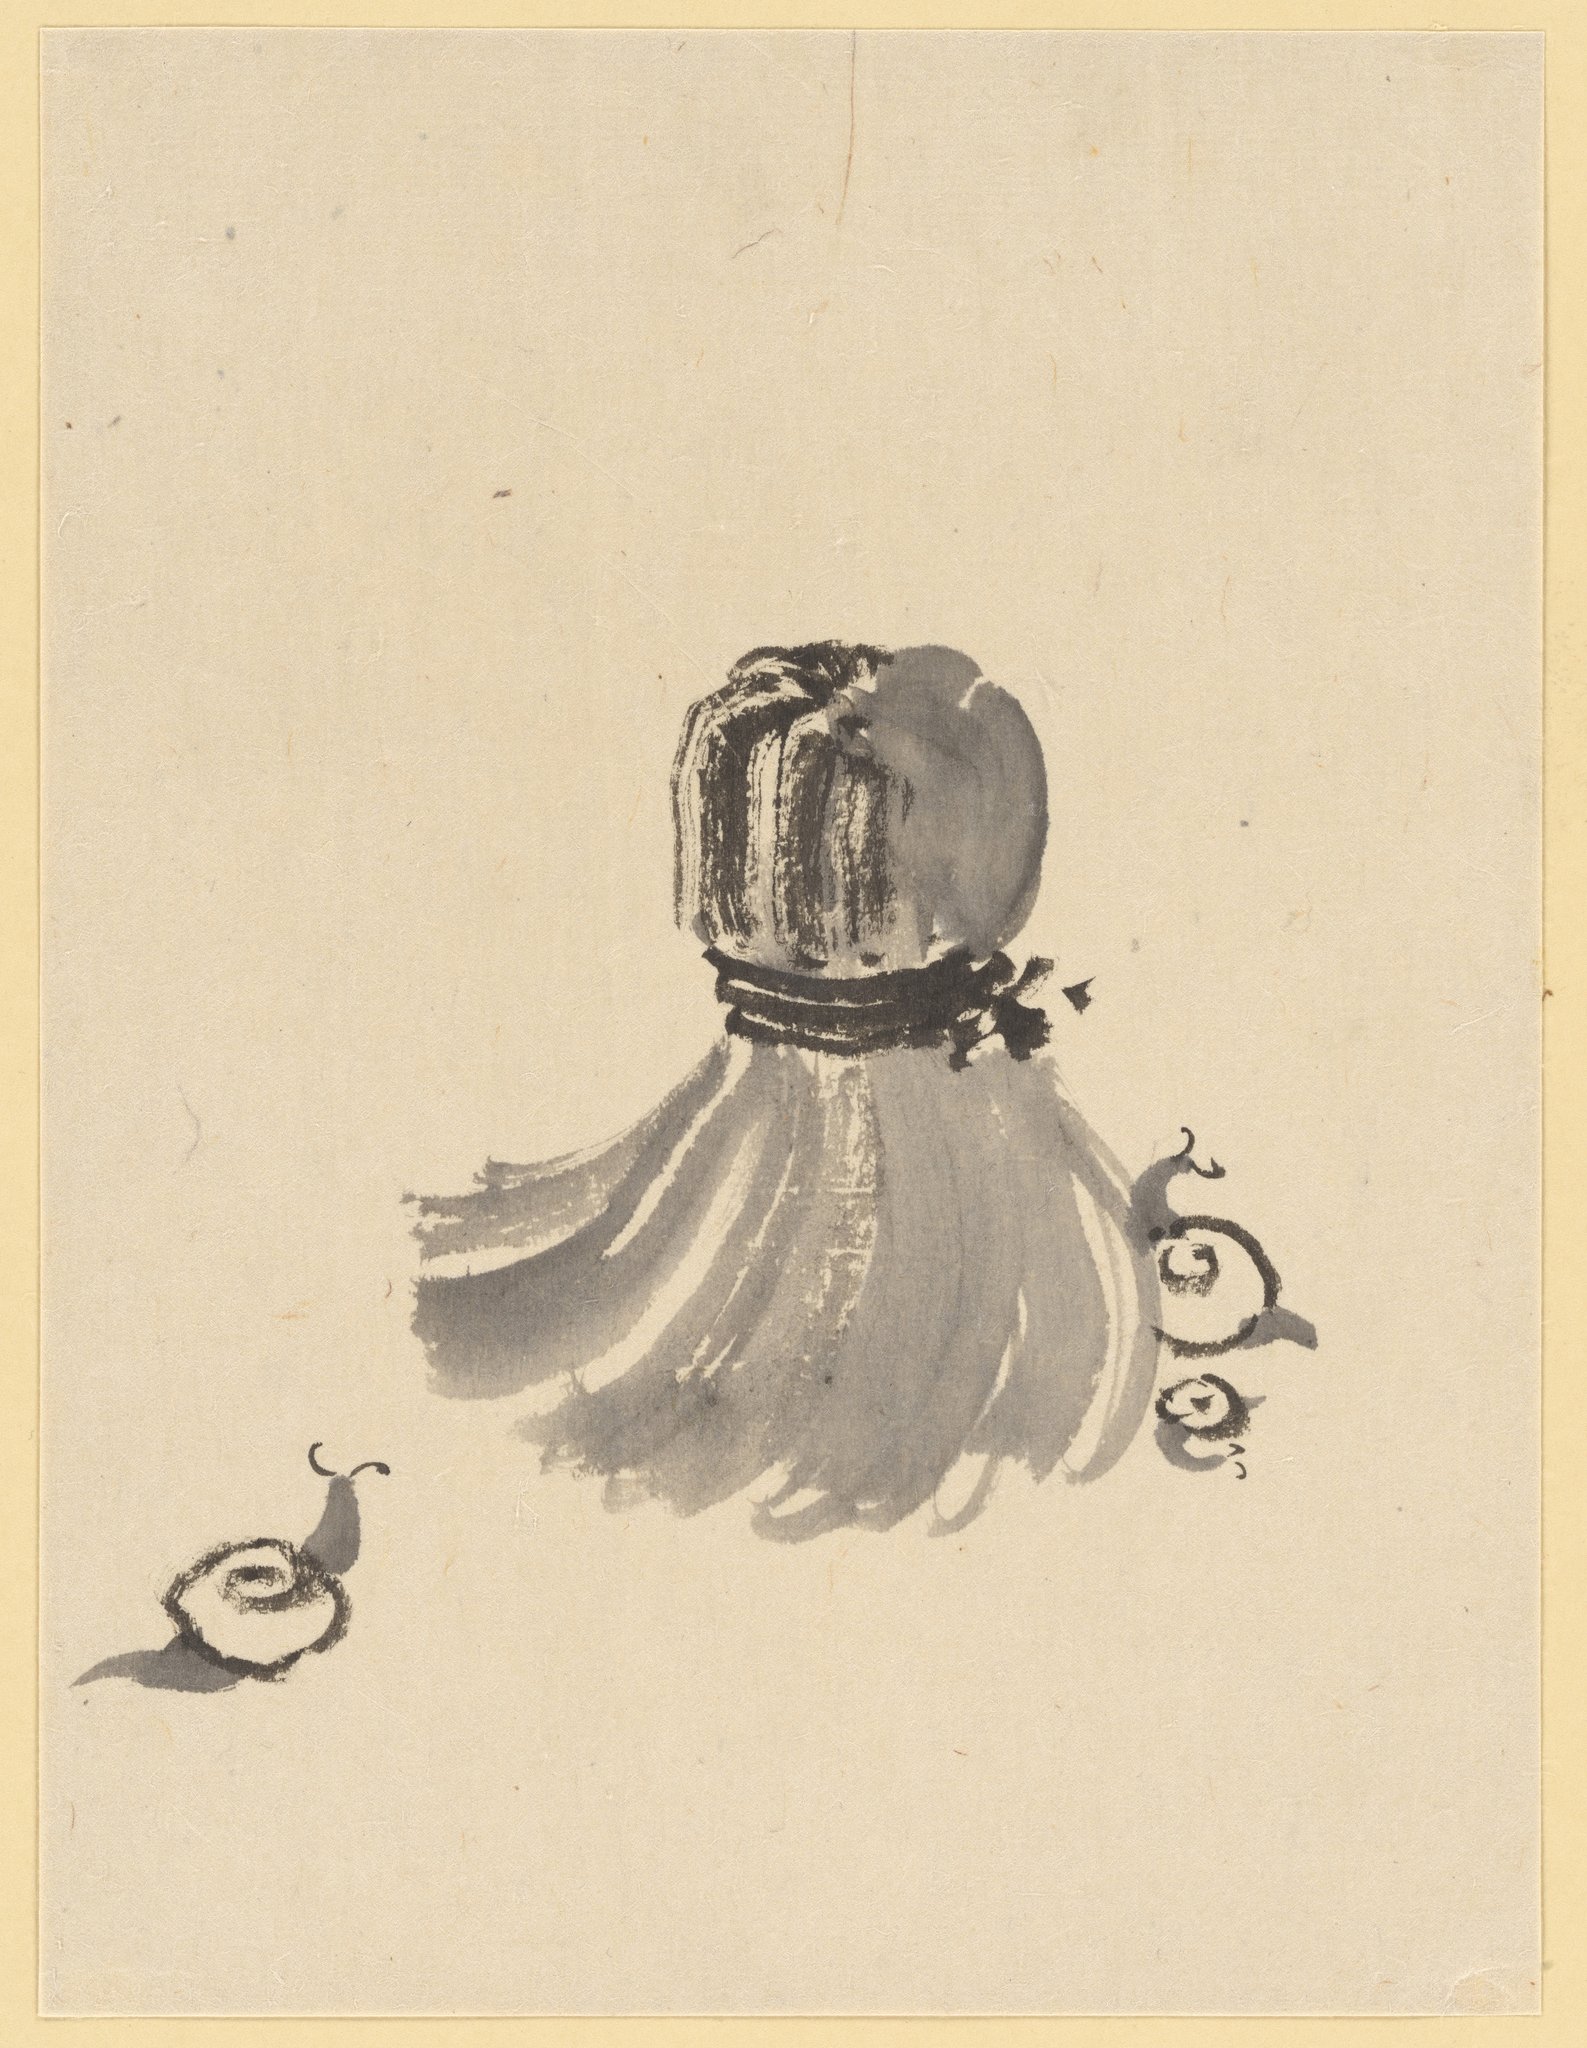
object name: drawing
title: Snails and Tawashi Scrubber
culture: japanese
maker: katsushika hokusai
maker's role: artist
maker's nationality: japanese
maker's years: 1760-1849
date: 1701-1900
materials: ink, paper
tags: snails